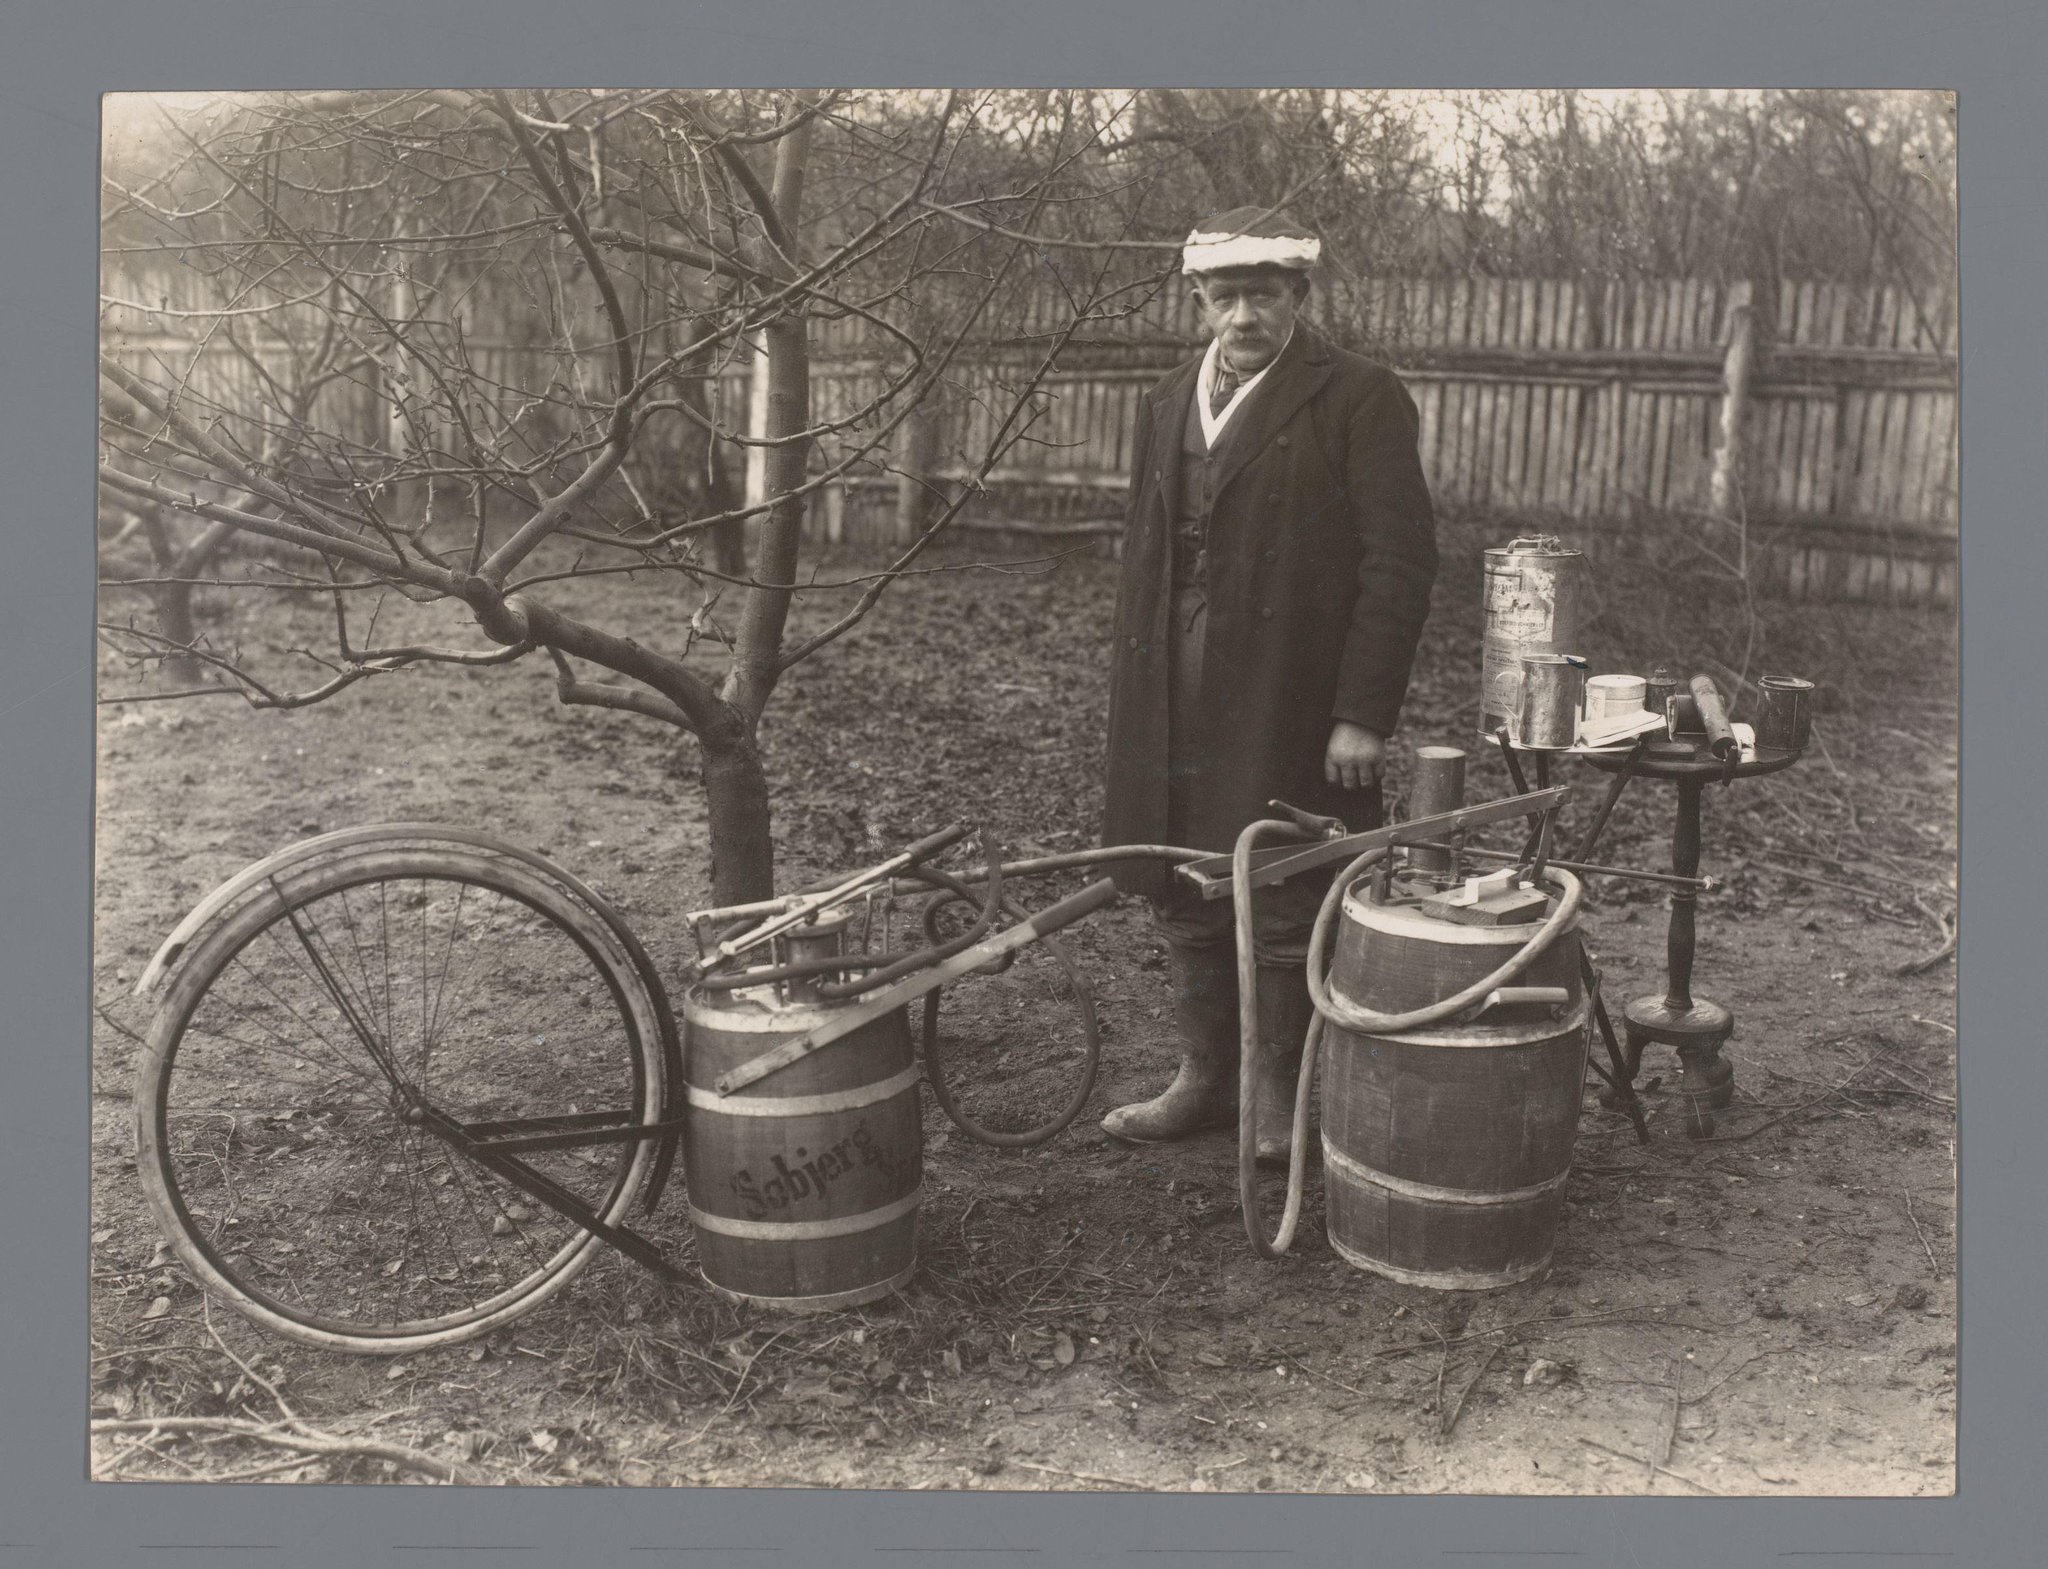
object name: photograph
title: Man bij zelfgebouwde gifspuitinstallatie voor vruchtenbomen, mogelijk in Denemarken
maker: Anonymous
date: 1900-1930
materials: paper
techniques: gelatin silver print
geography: denmark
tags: fruit-tree culture; fruit harvest, adult man, denmark